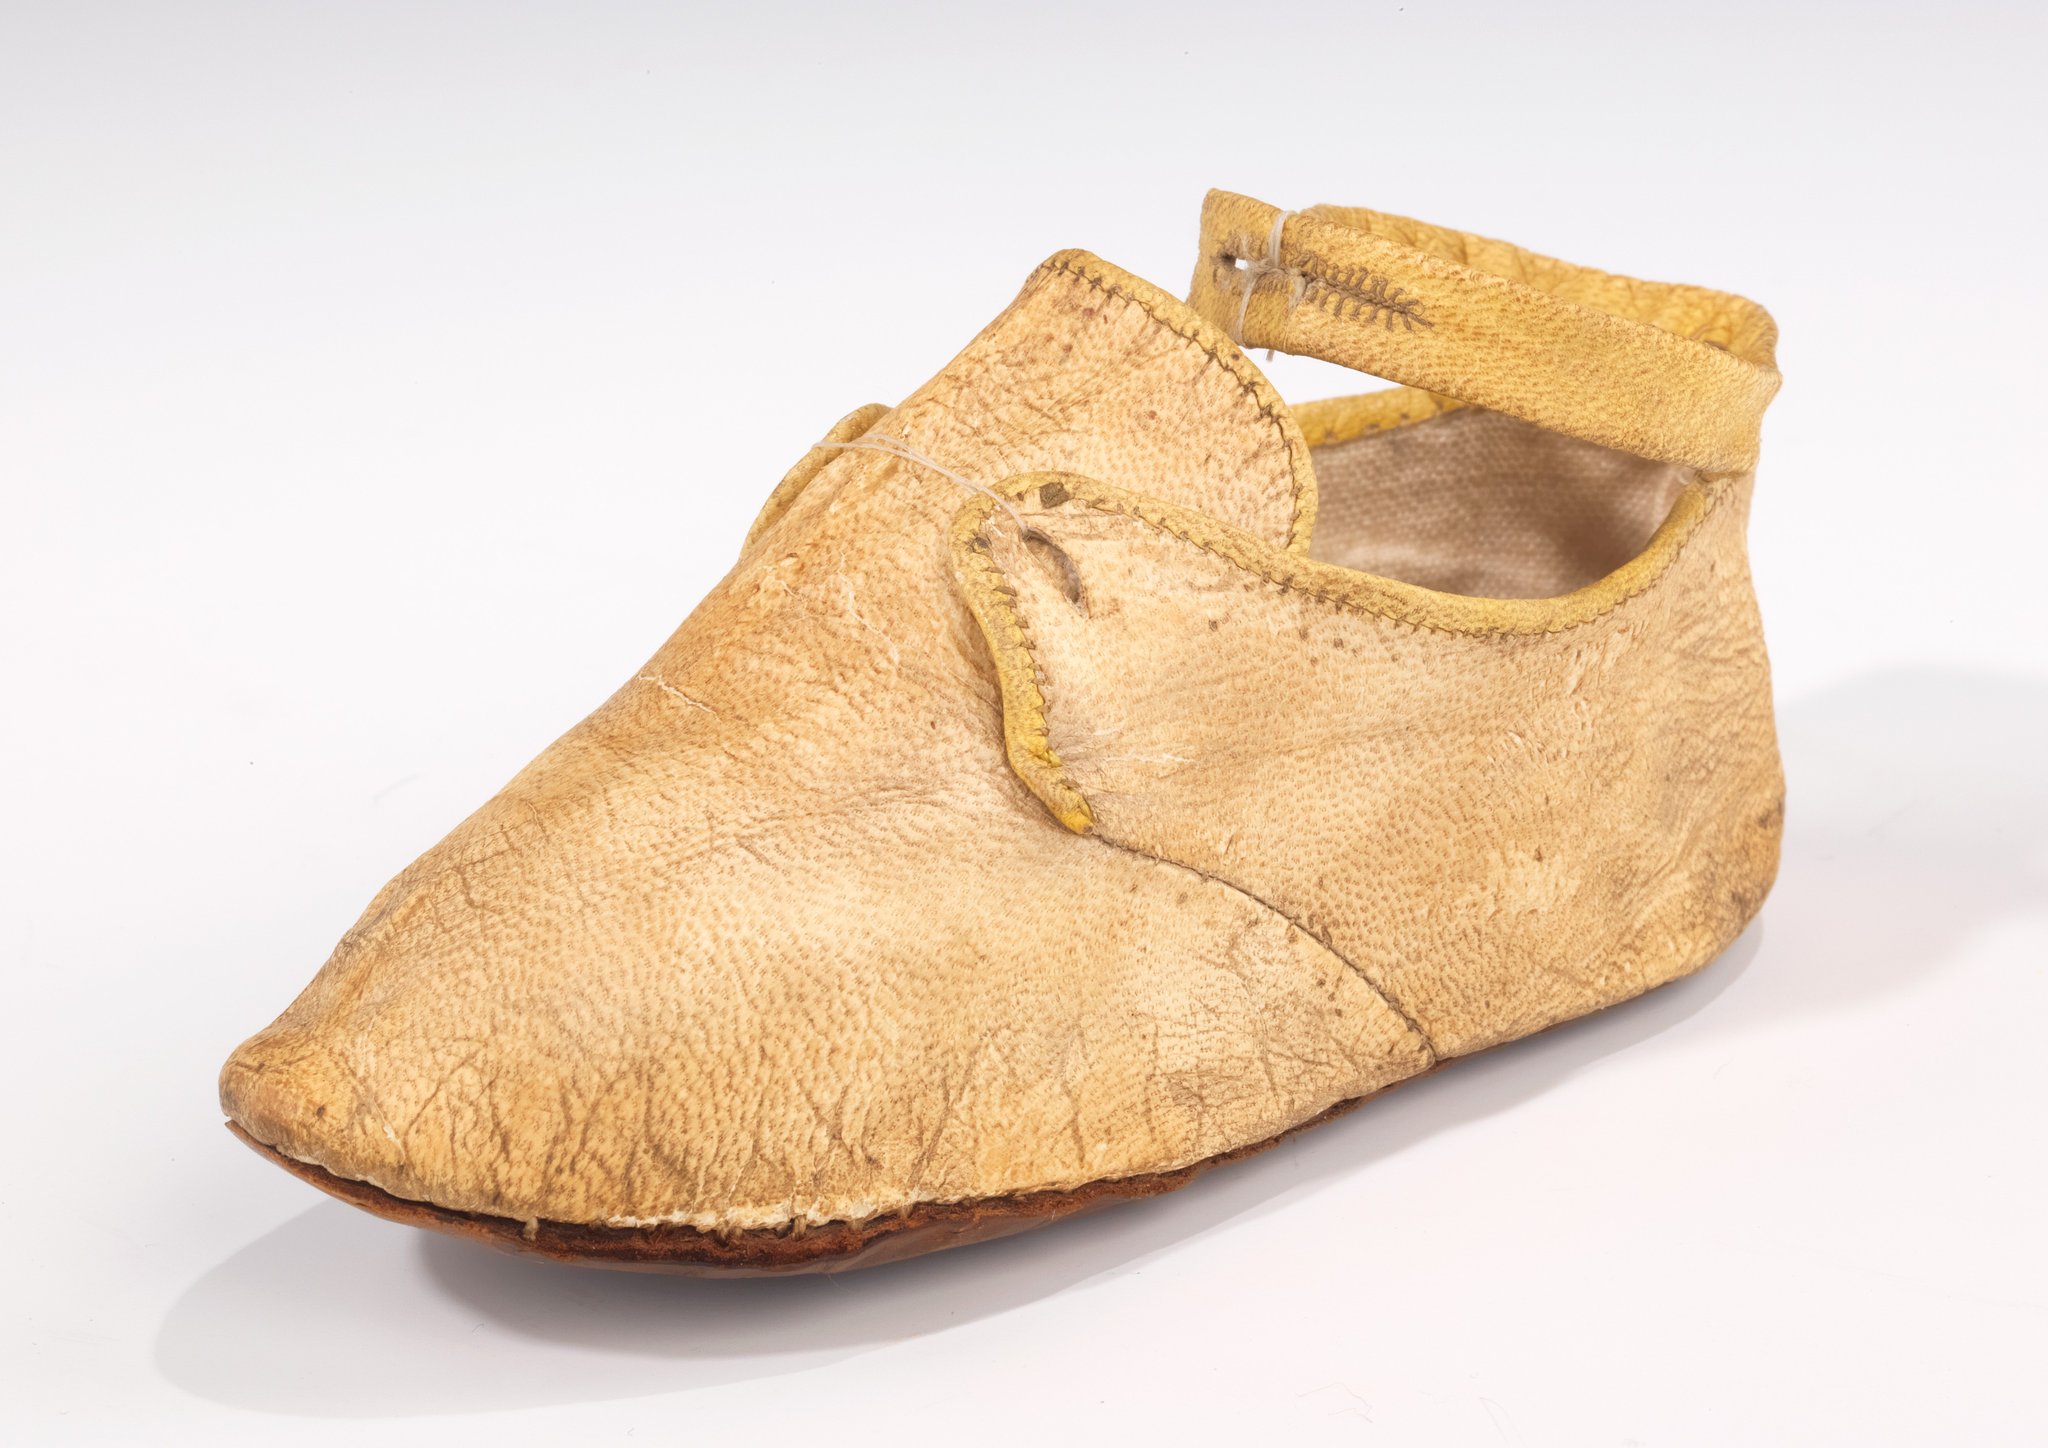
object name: shoe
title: Shoes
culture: european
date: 1775-1825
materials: leather